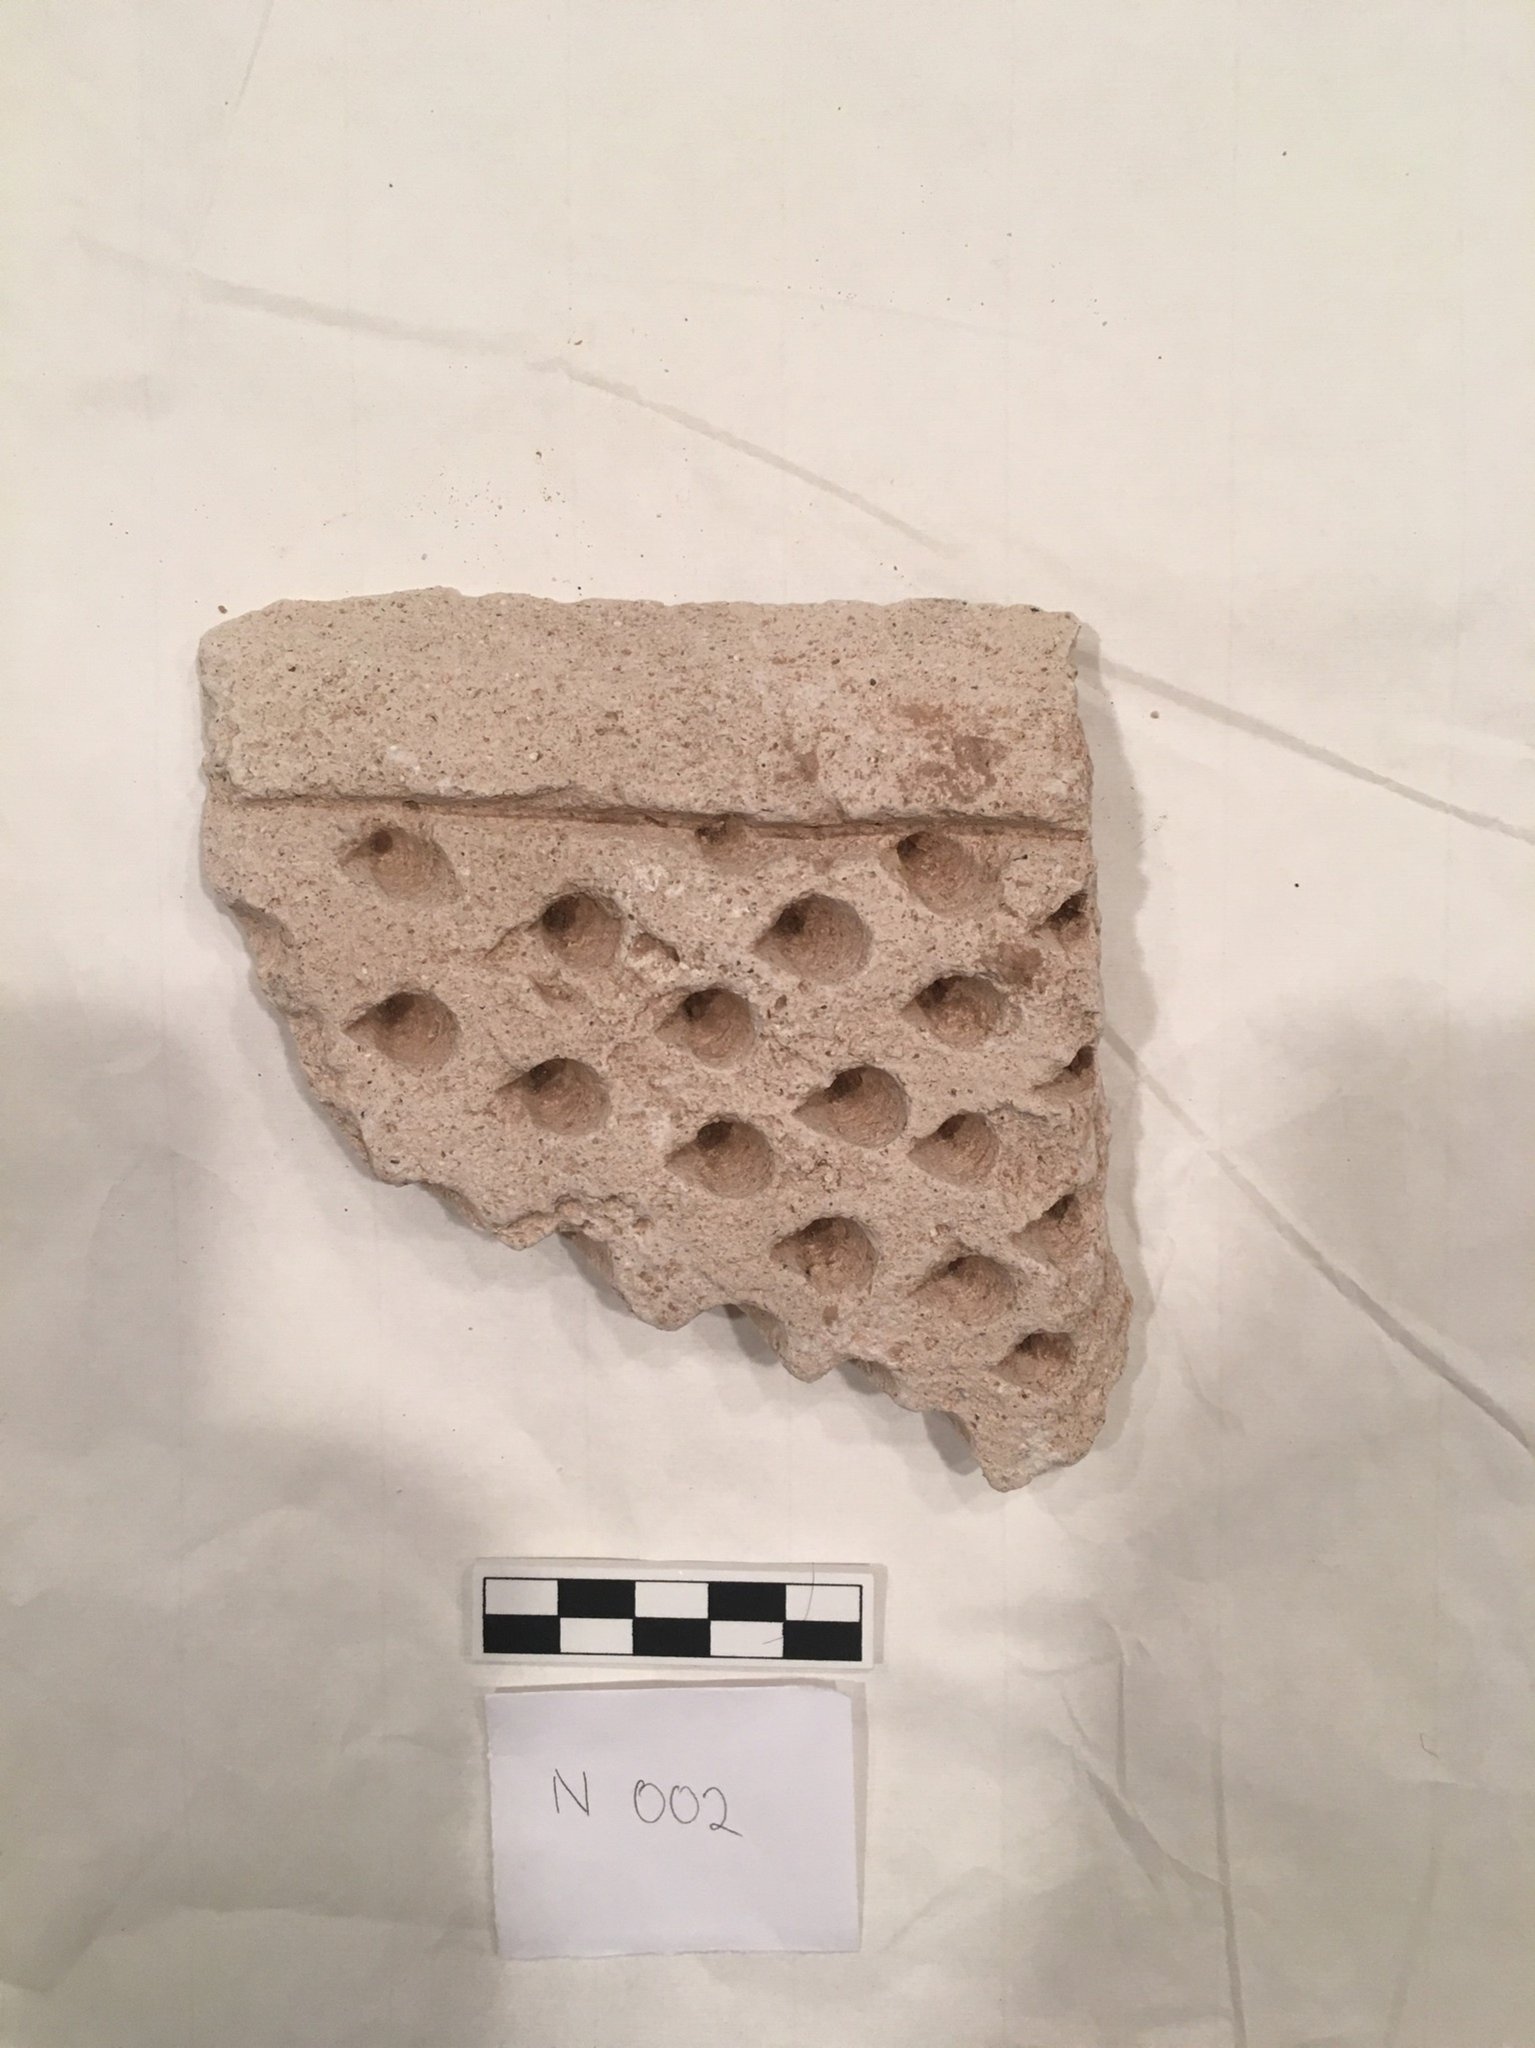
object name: fragment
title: Stucco Fragment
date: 701-1200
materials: pigment, plaster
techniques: carving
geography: iran